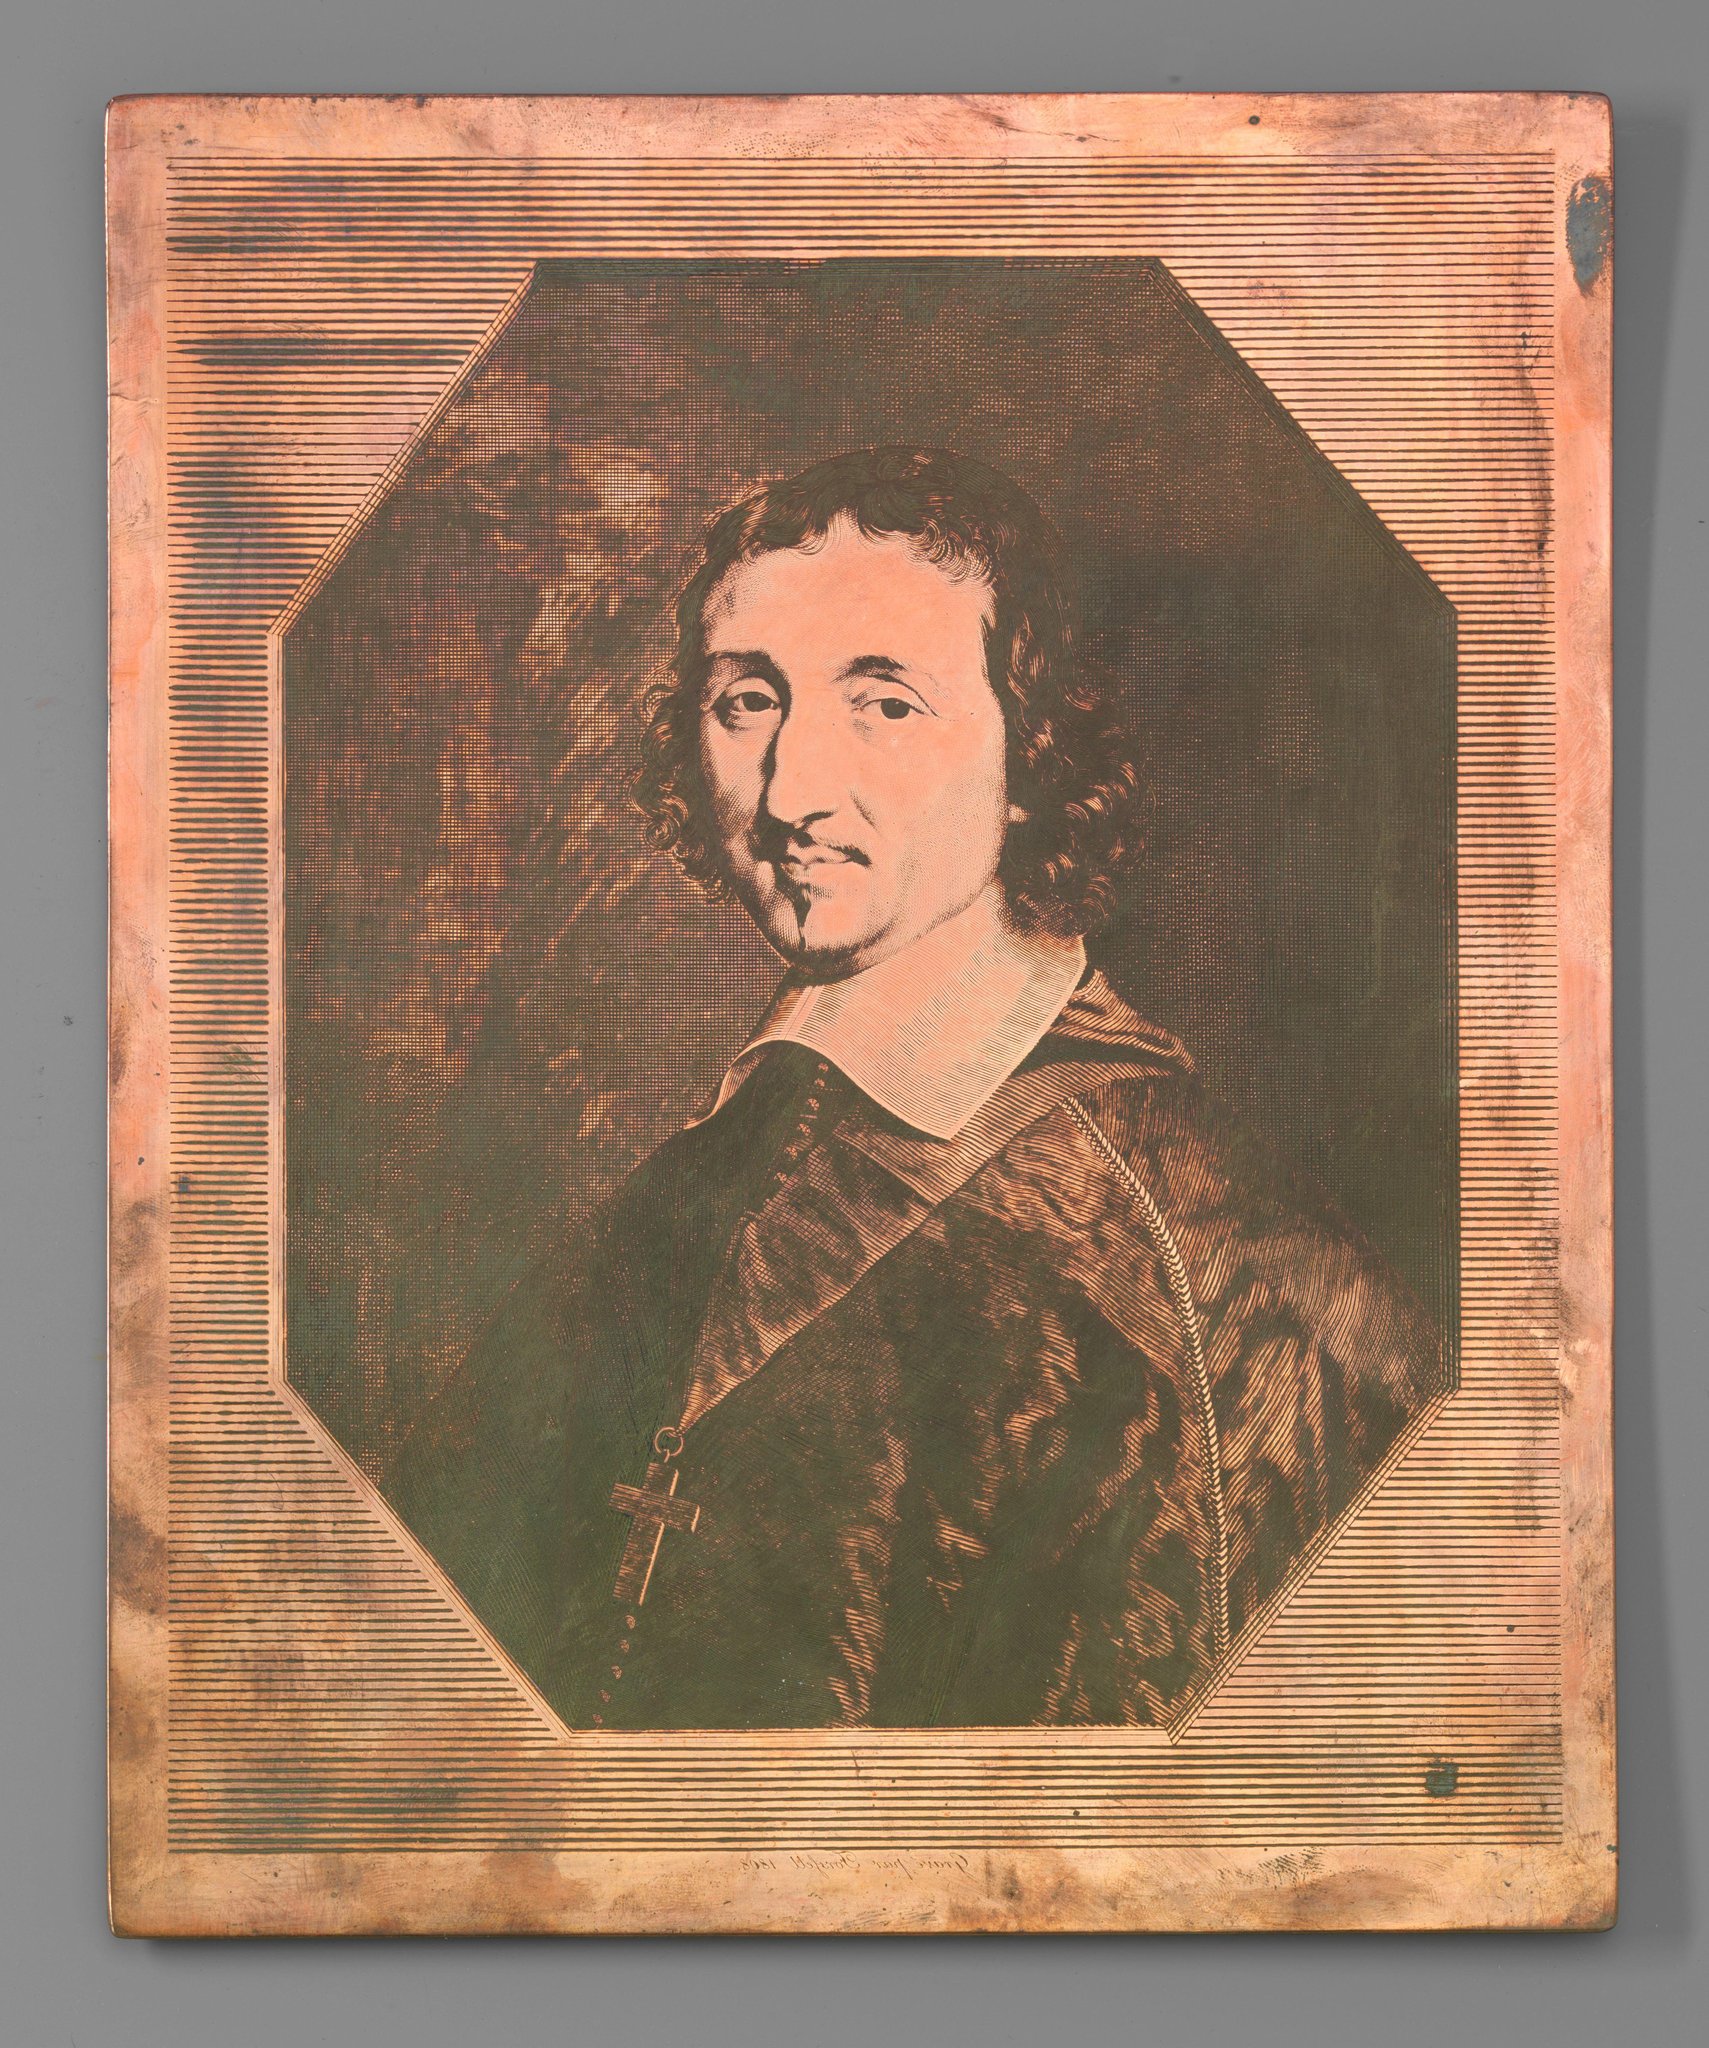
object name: copper plate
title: Portret van Ferdinand de Neufville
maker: christian forssell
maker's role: print maker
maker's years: 1777-1852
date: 1808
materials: copper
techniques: engraving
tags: paris, clergyman